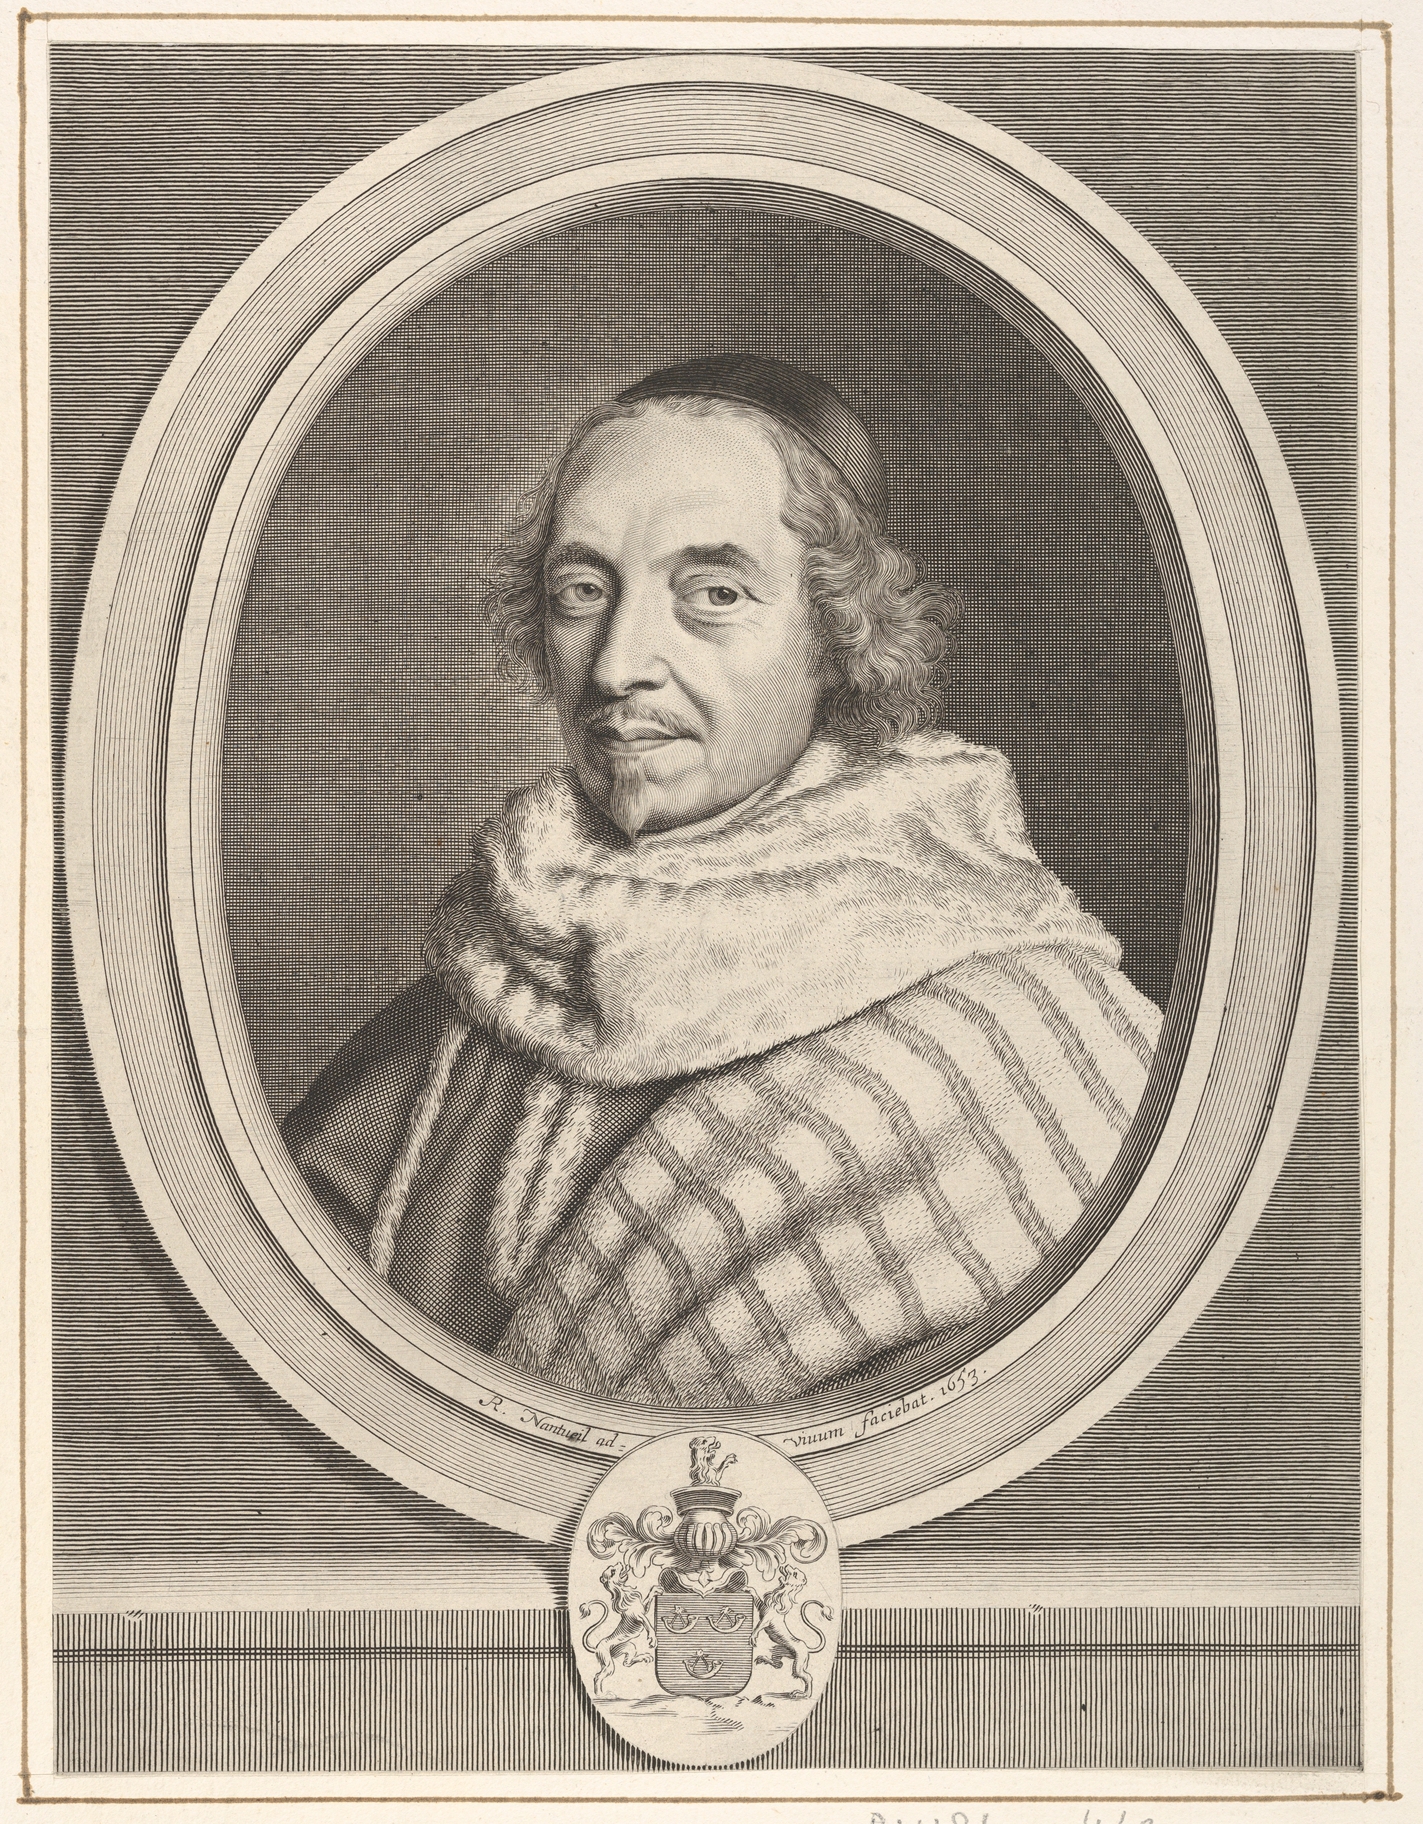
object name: print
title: François-Théodore de Nesmond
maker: robert nanteuil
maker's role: artist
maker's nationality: french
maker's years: 1623-1678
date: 1653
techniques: engraving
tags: men,portraits,coat of arms